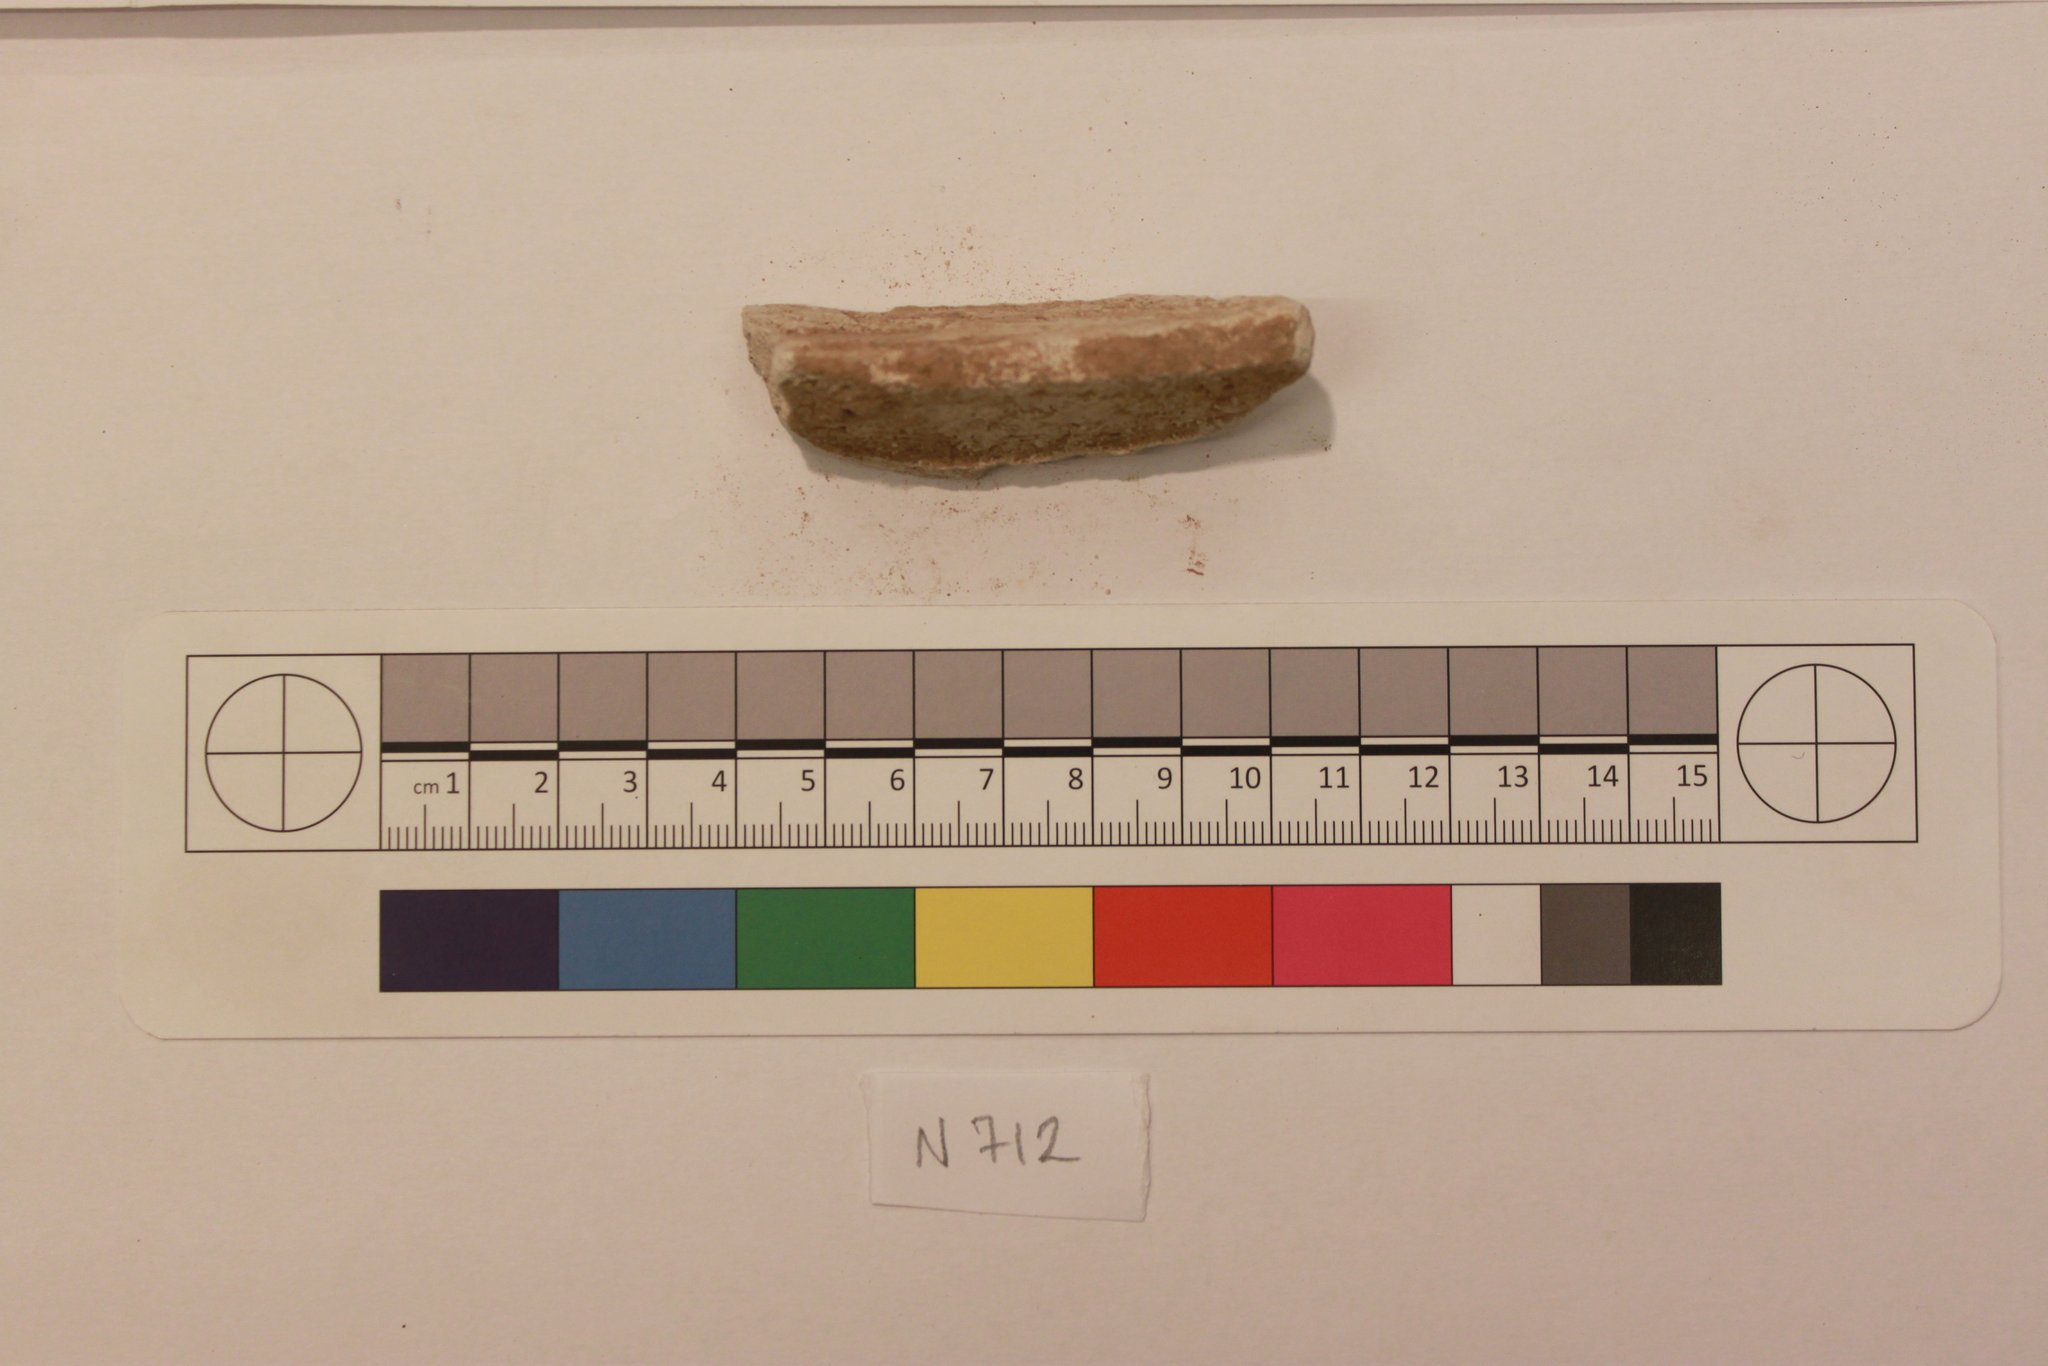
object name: fragment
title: Stucco Fragment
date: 701-1200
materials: plaster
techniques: carving, painting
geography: iran